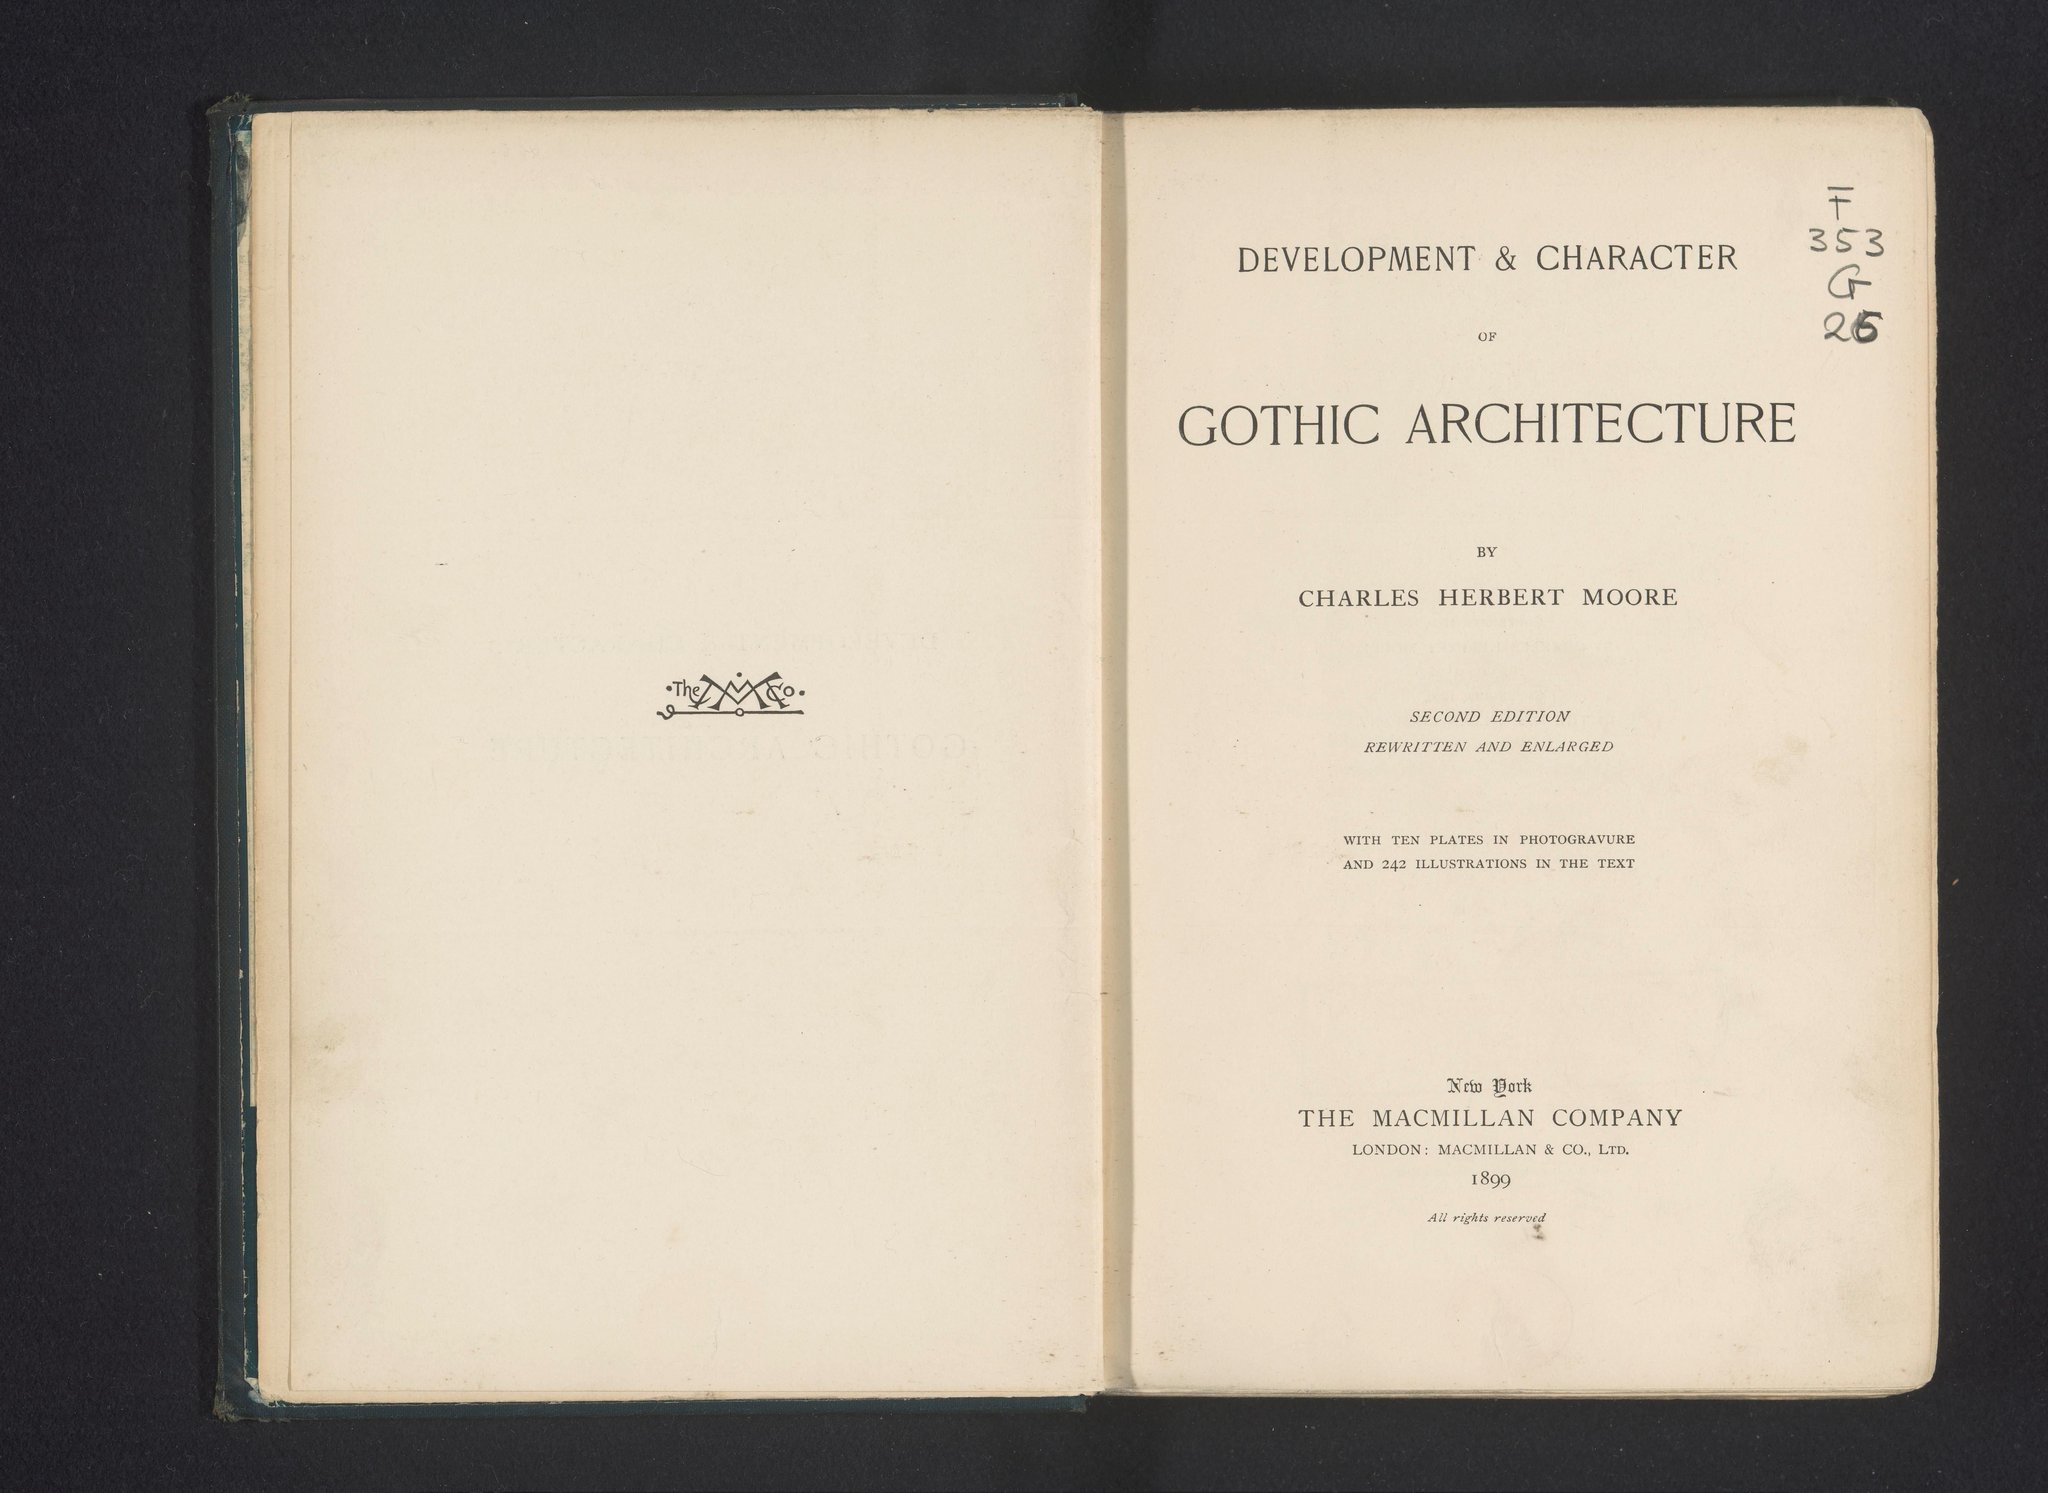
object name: book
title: Development and character of gothic architecture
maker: charles herbert moore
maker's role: painter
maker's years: 1840-1930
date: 1890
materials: linen, paper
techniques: photoaquatint, printing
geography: london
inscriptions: inscription, name: ‘ex libris SFJ’